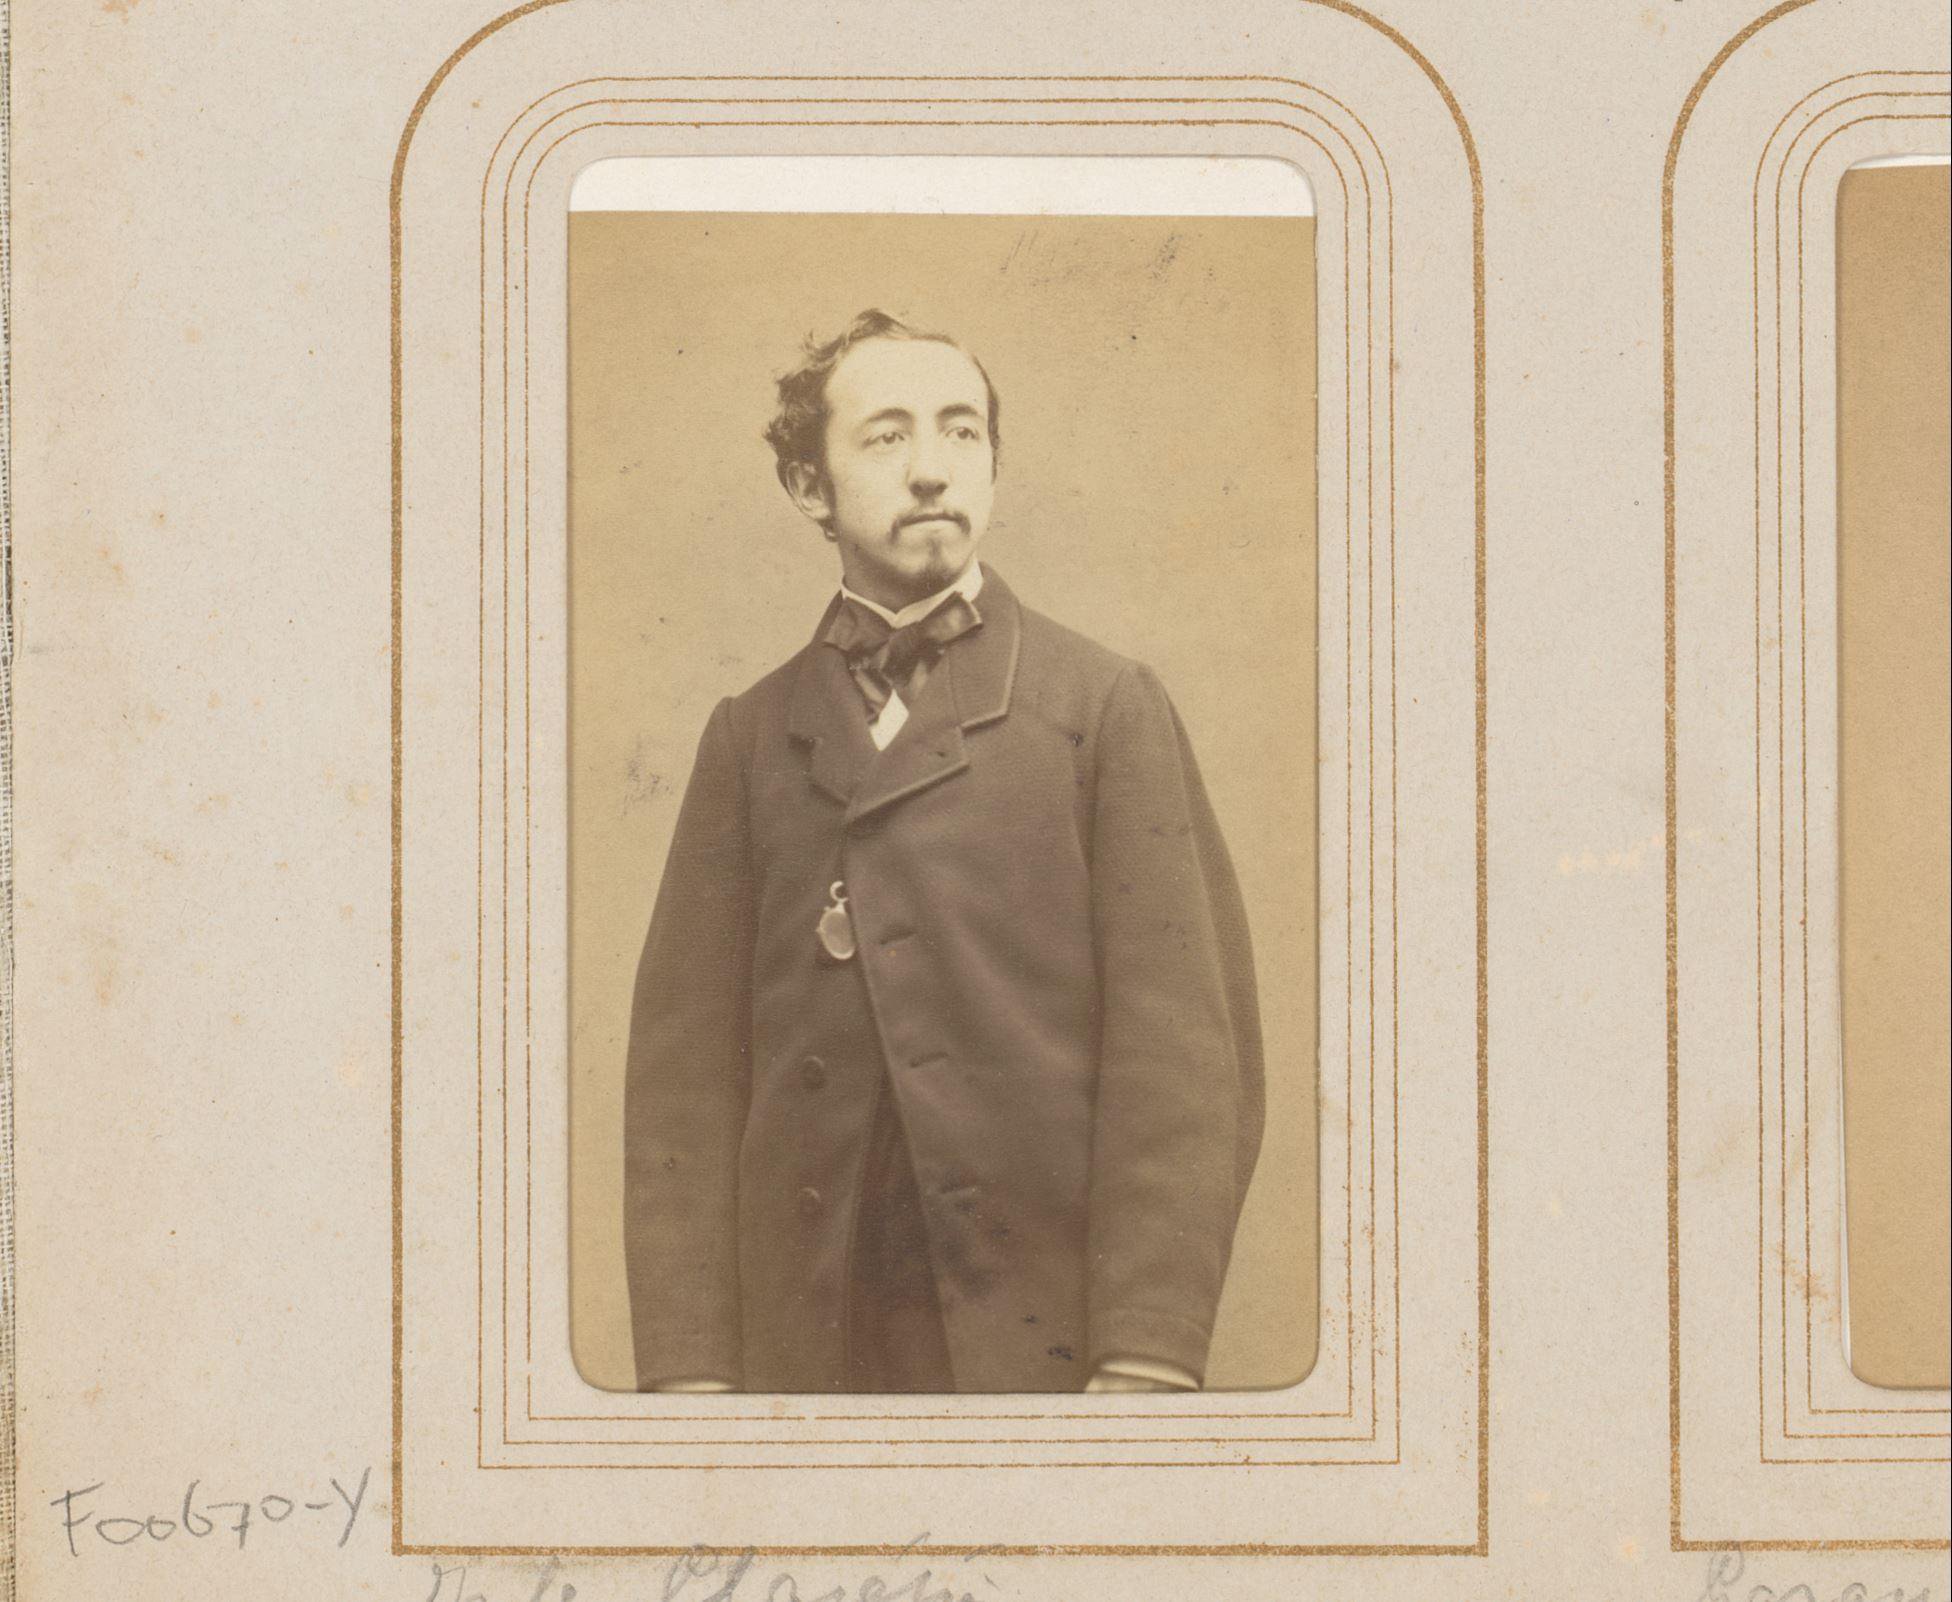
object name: photograph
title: Portret van Jules Claretie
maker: georges mathurin legé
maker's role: fotograaf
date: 1865-1880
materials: cardboard, photographic support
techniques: albumen print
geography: paris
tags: jules claretie, historical persons, writer, poet, author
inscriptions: annotation: ‘Jules Claretie/ fr. schrijver en criticus 1840-/ (Legé Carjat)’, inscription: ‘G.M. Legé/ Photographe/ ancien associé. succr/ De Carjat & Cie/ 56, Rue Laffitte/ Paris’